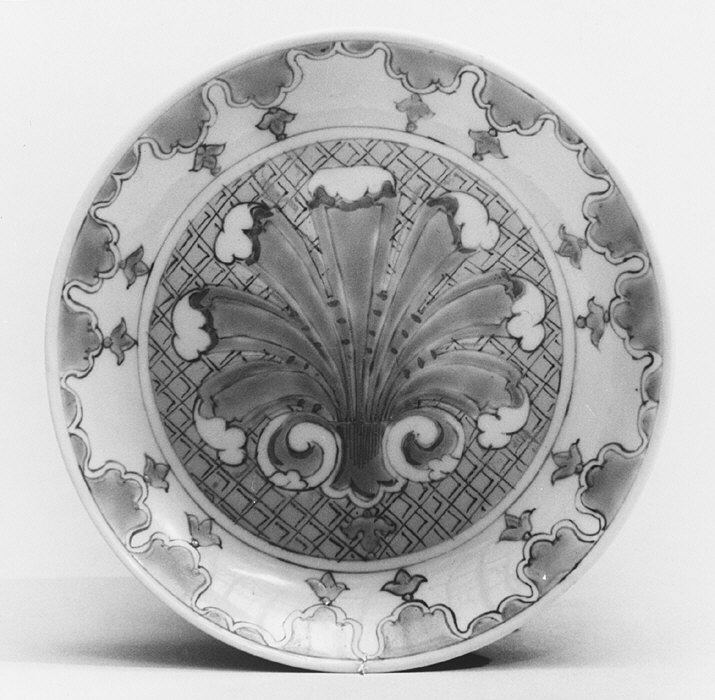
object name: saucer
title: Saucer (part of a service)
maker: cornelis pronk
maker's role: artist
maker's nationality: dutch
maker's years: 1691-1759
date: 1740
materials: hard paste porcelain